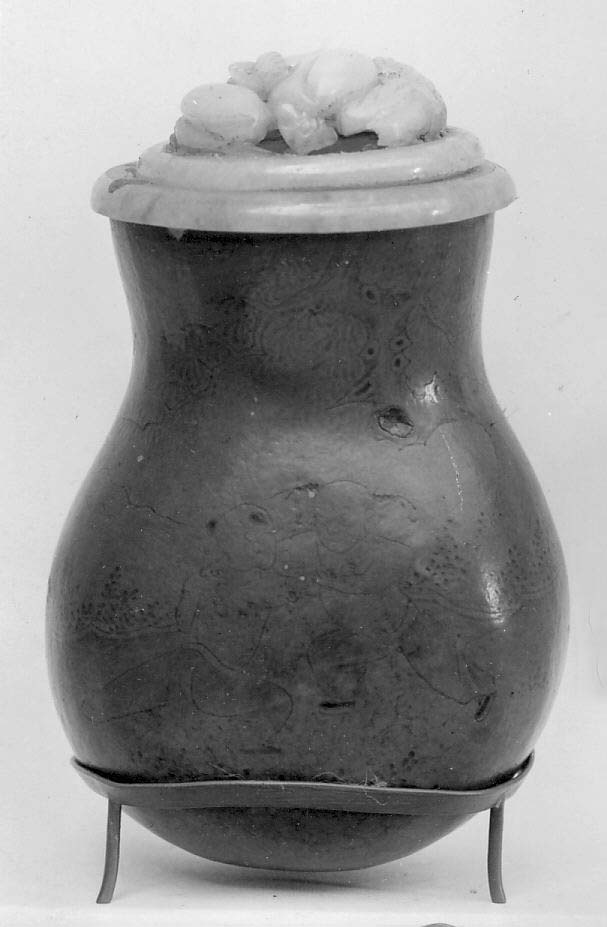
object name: cricket cage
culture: chinese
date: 1701-1900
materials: jade